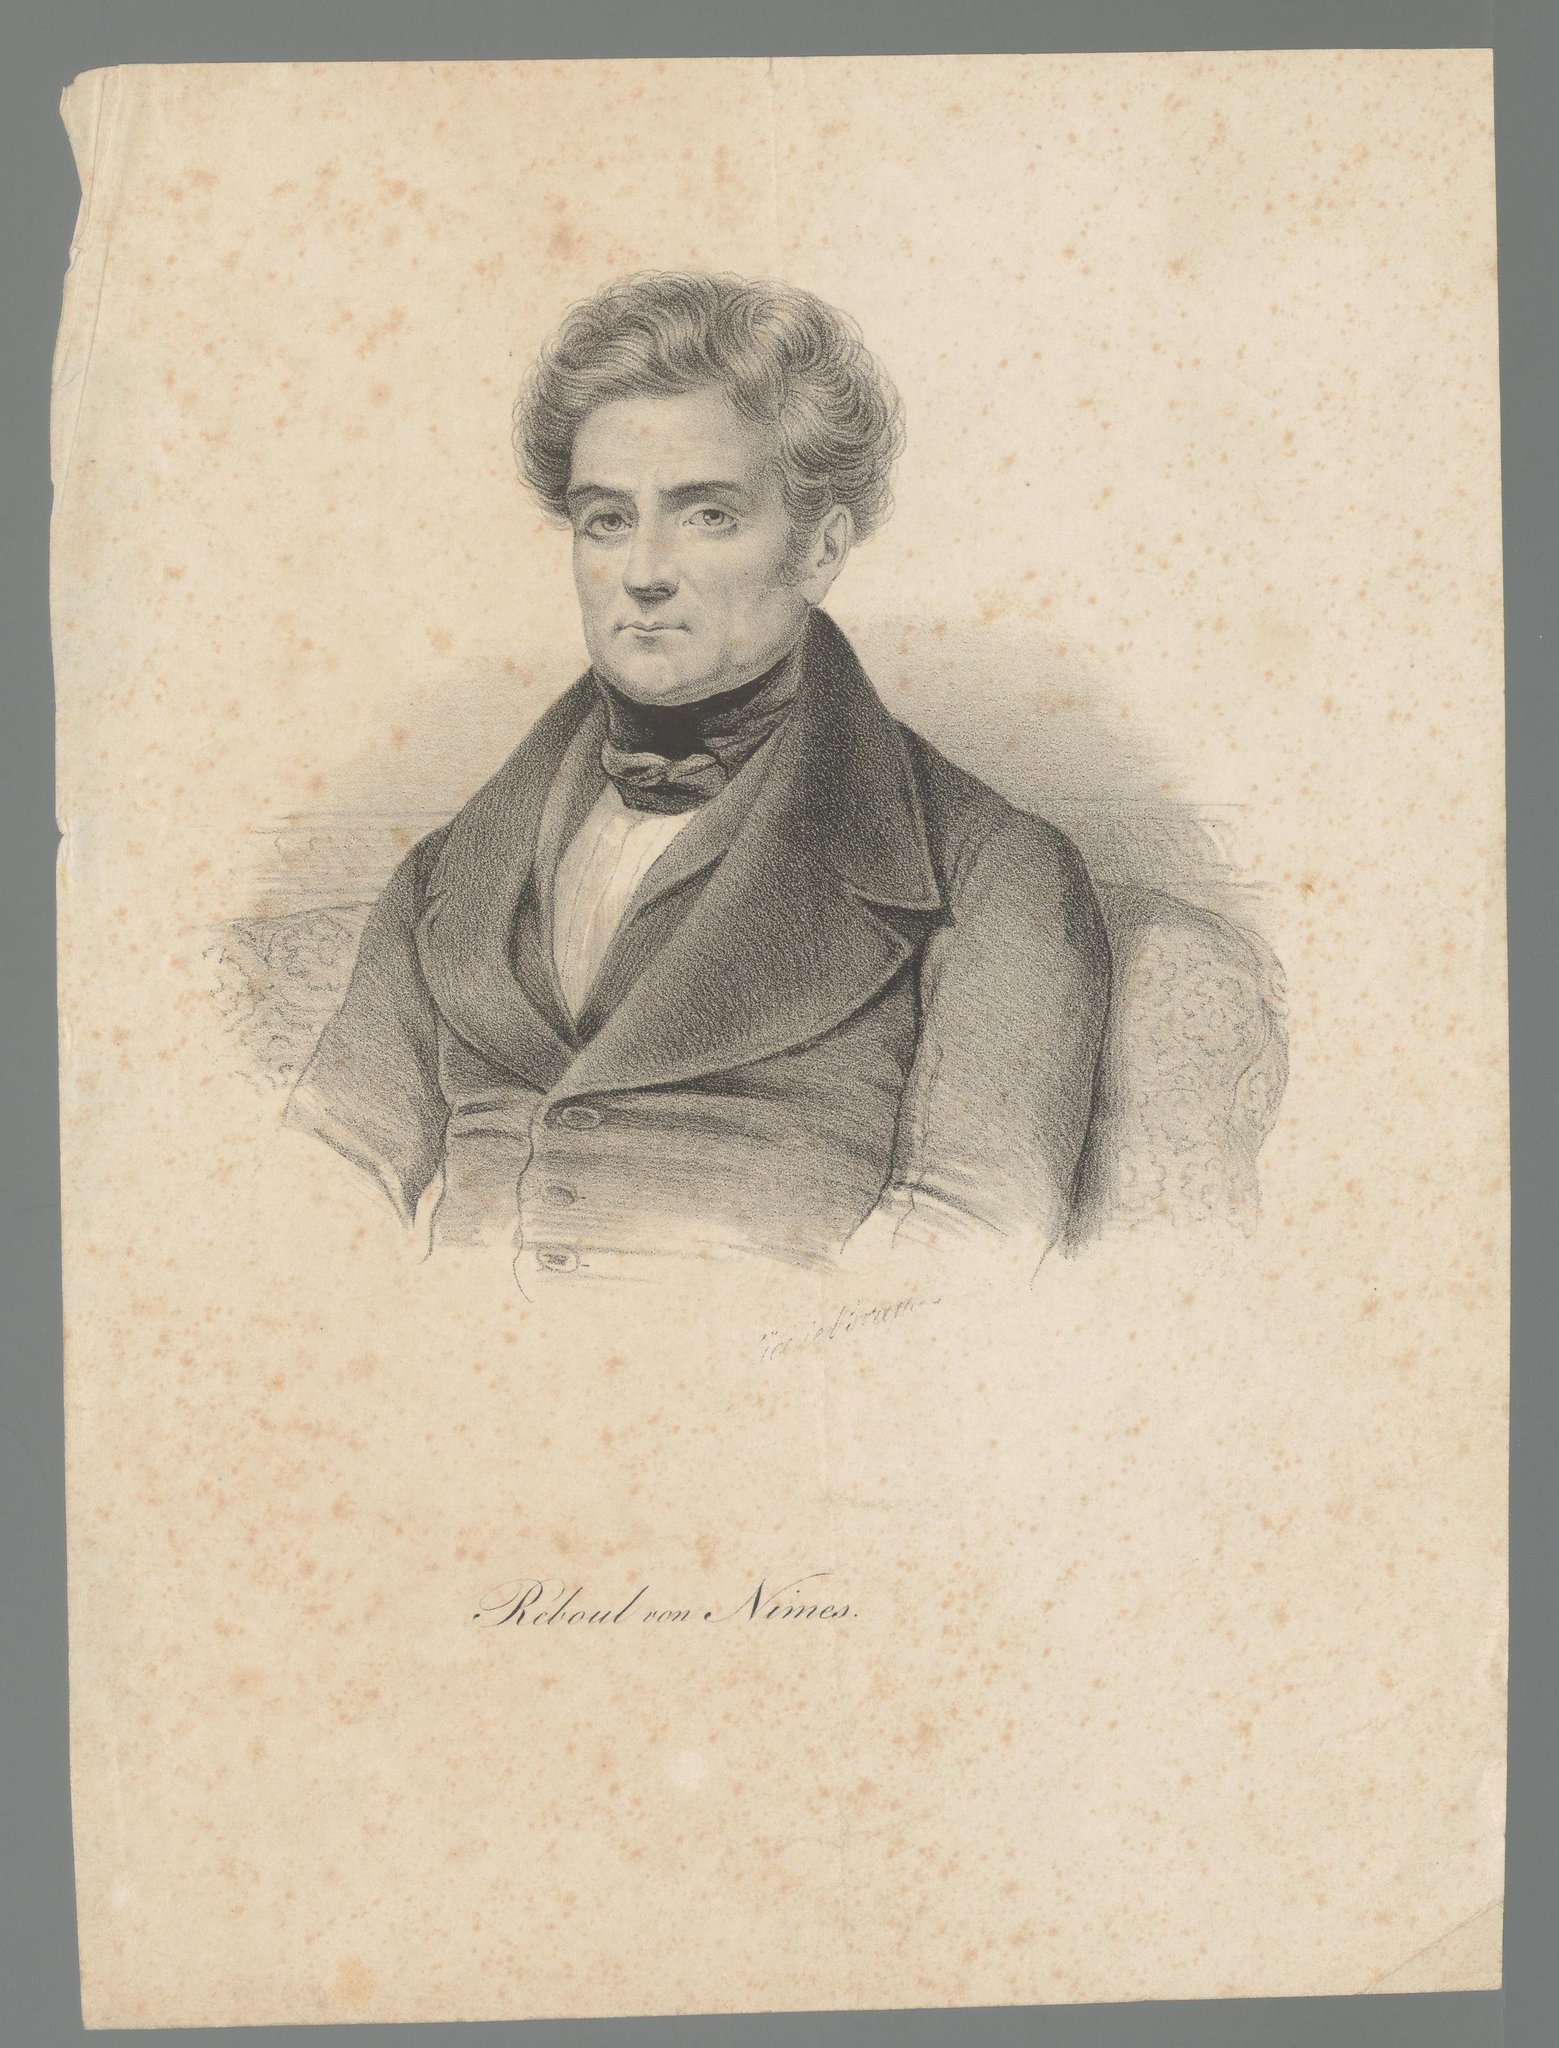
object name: print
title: Portret van Jean Reboul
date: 1829-1839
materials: paper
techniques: lithograph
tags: adult man, historical persons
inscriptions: collector's mark: Lugt 2228